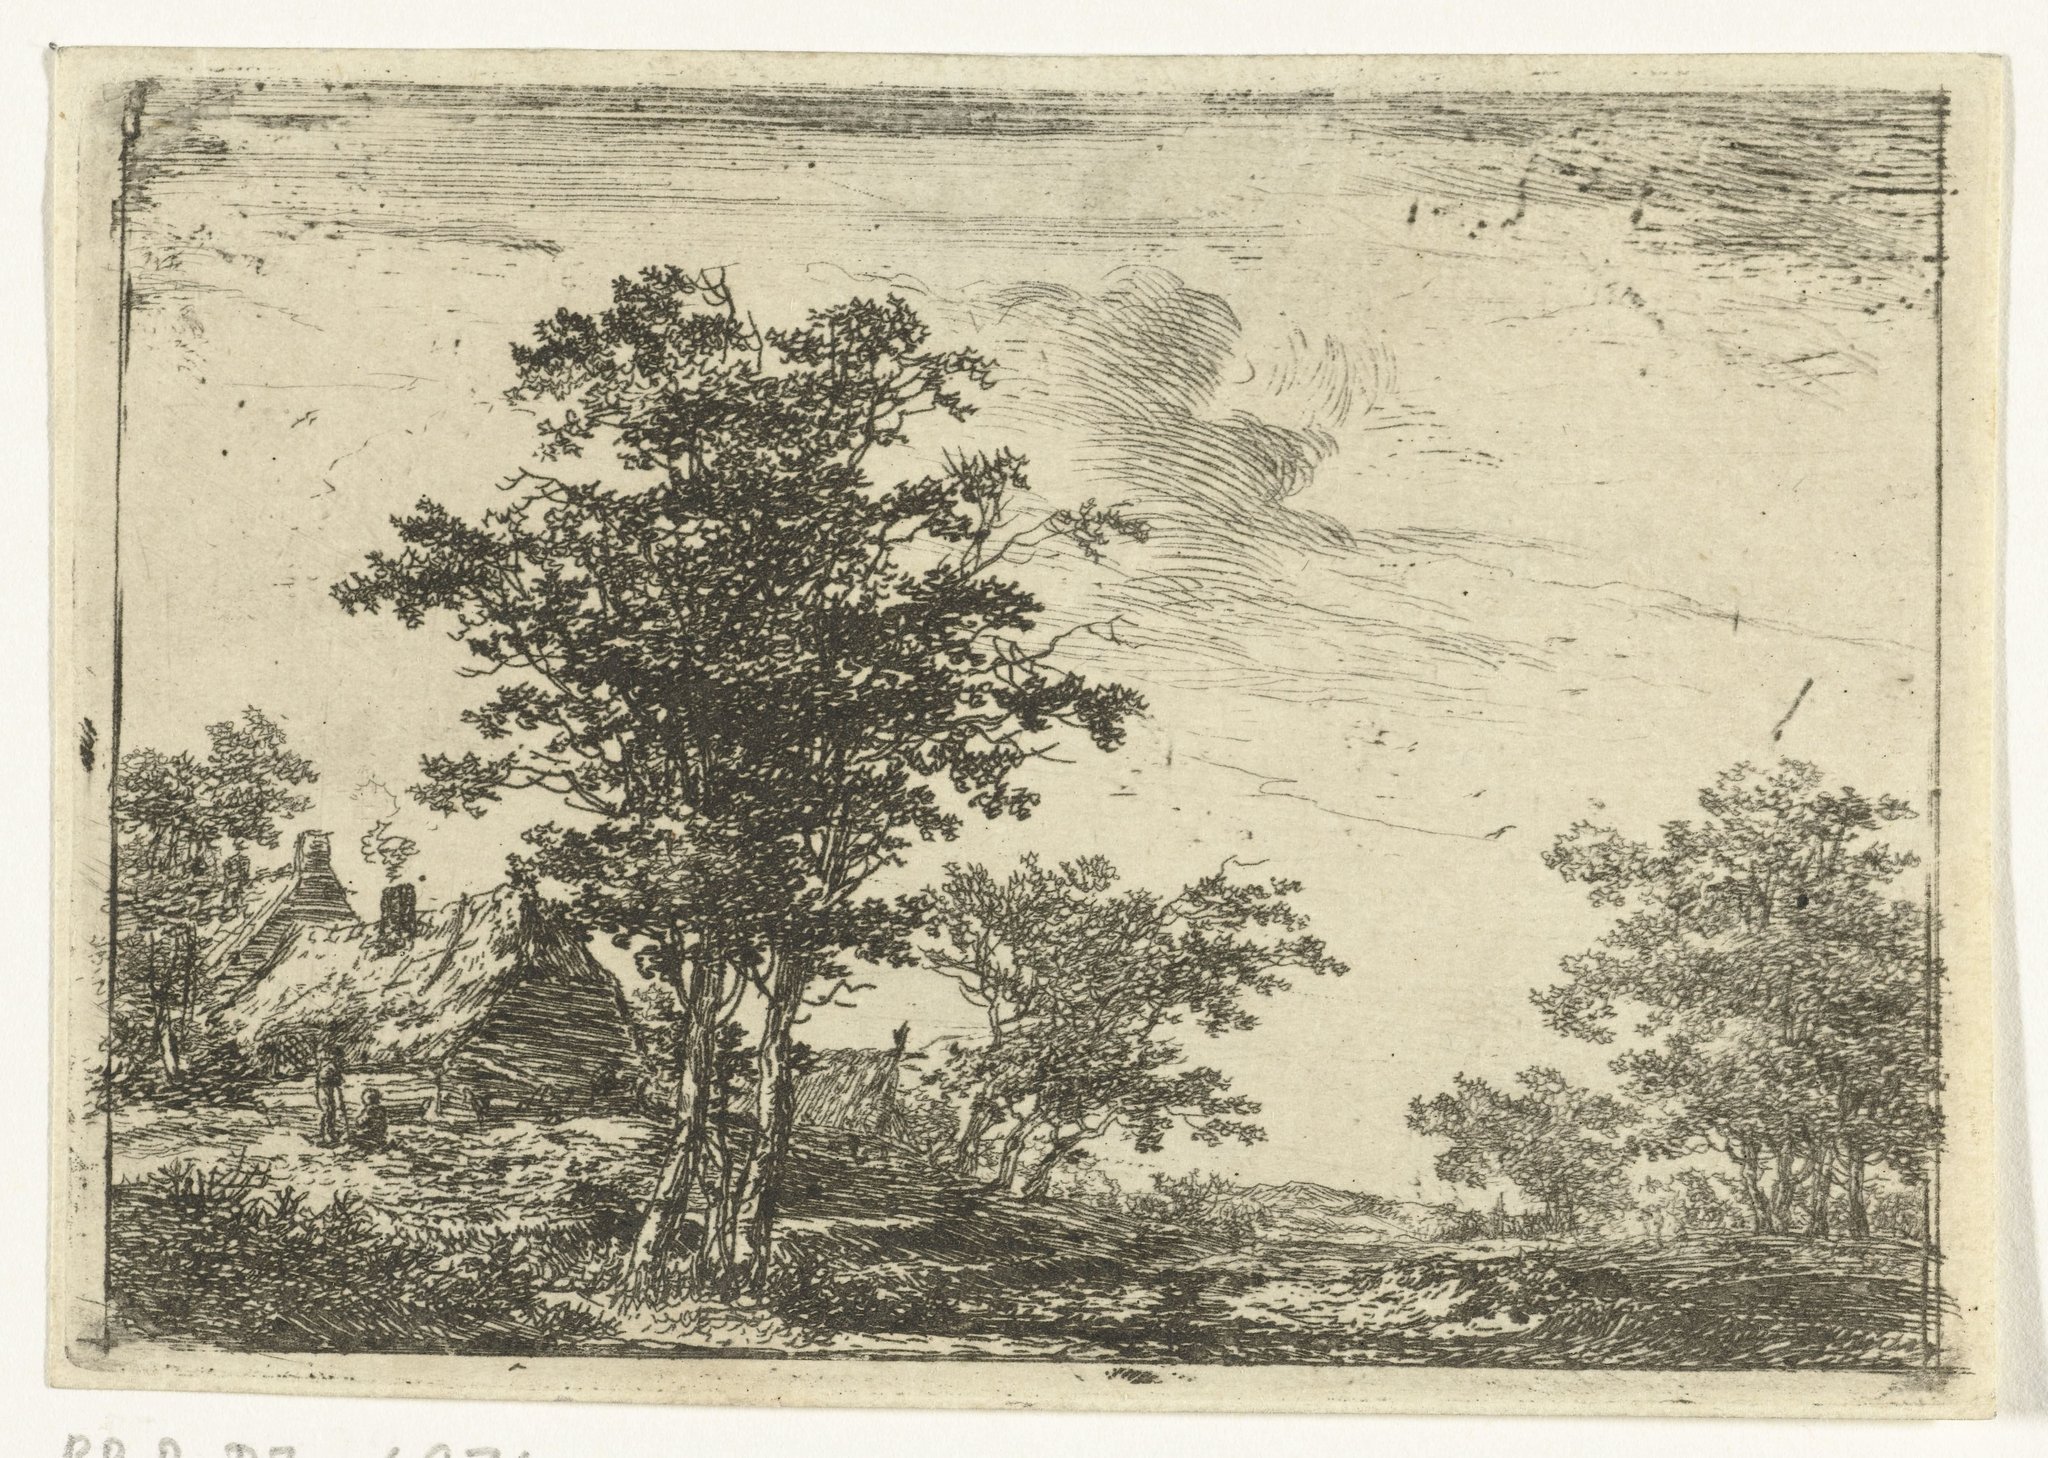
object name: print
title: Boerderij met rokende schoorsteen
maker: hermanus van brussel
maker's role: draughtsman, print maker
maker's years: 1763-1815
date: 1800-1815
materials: paper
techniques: drypoint, etching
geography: netherlands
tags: landscapes in the temperate zone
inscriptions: collector's mark: Lugt 2228